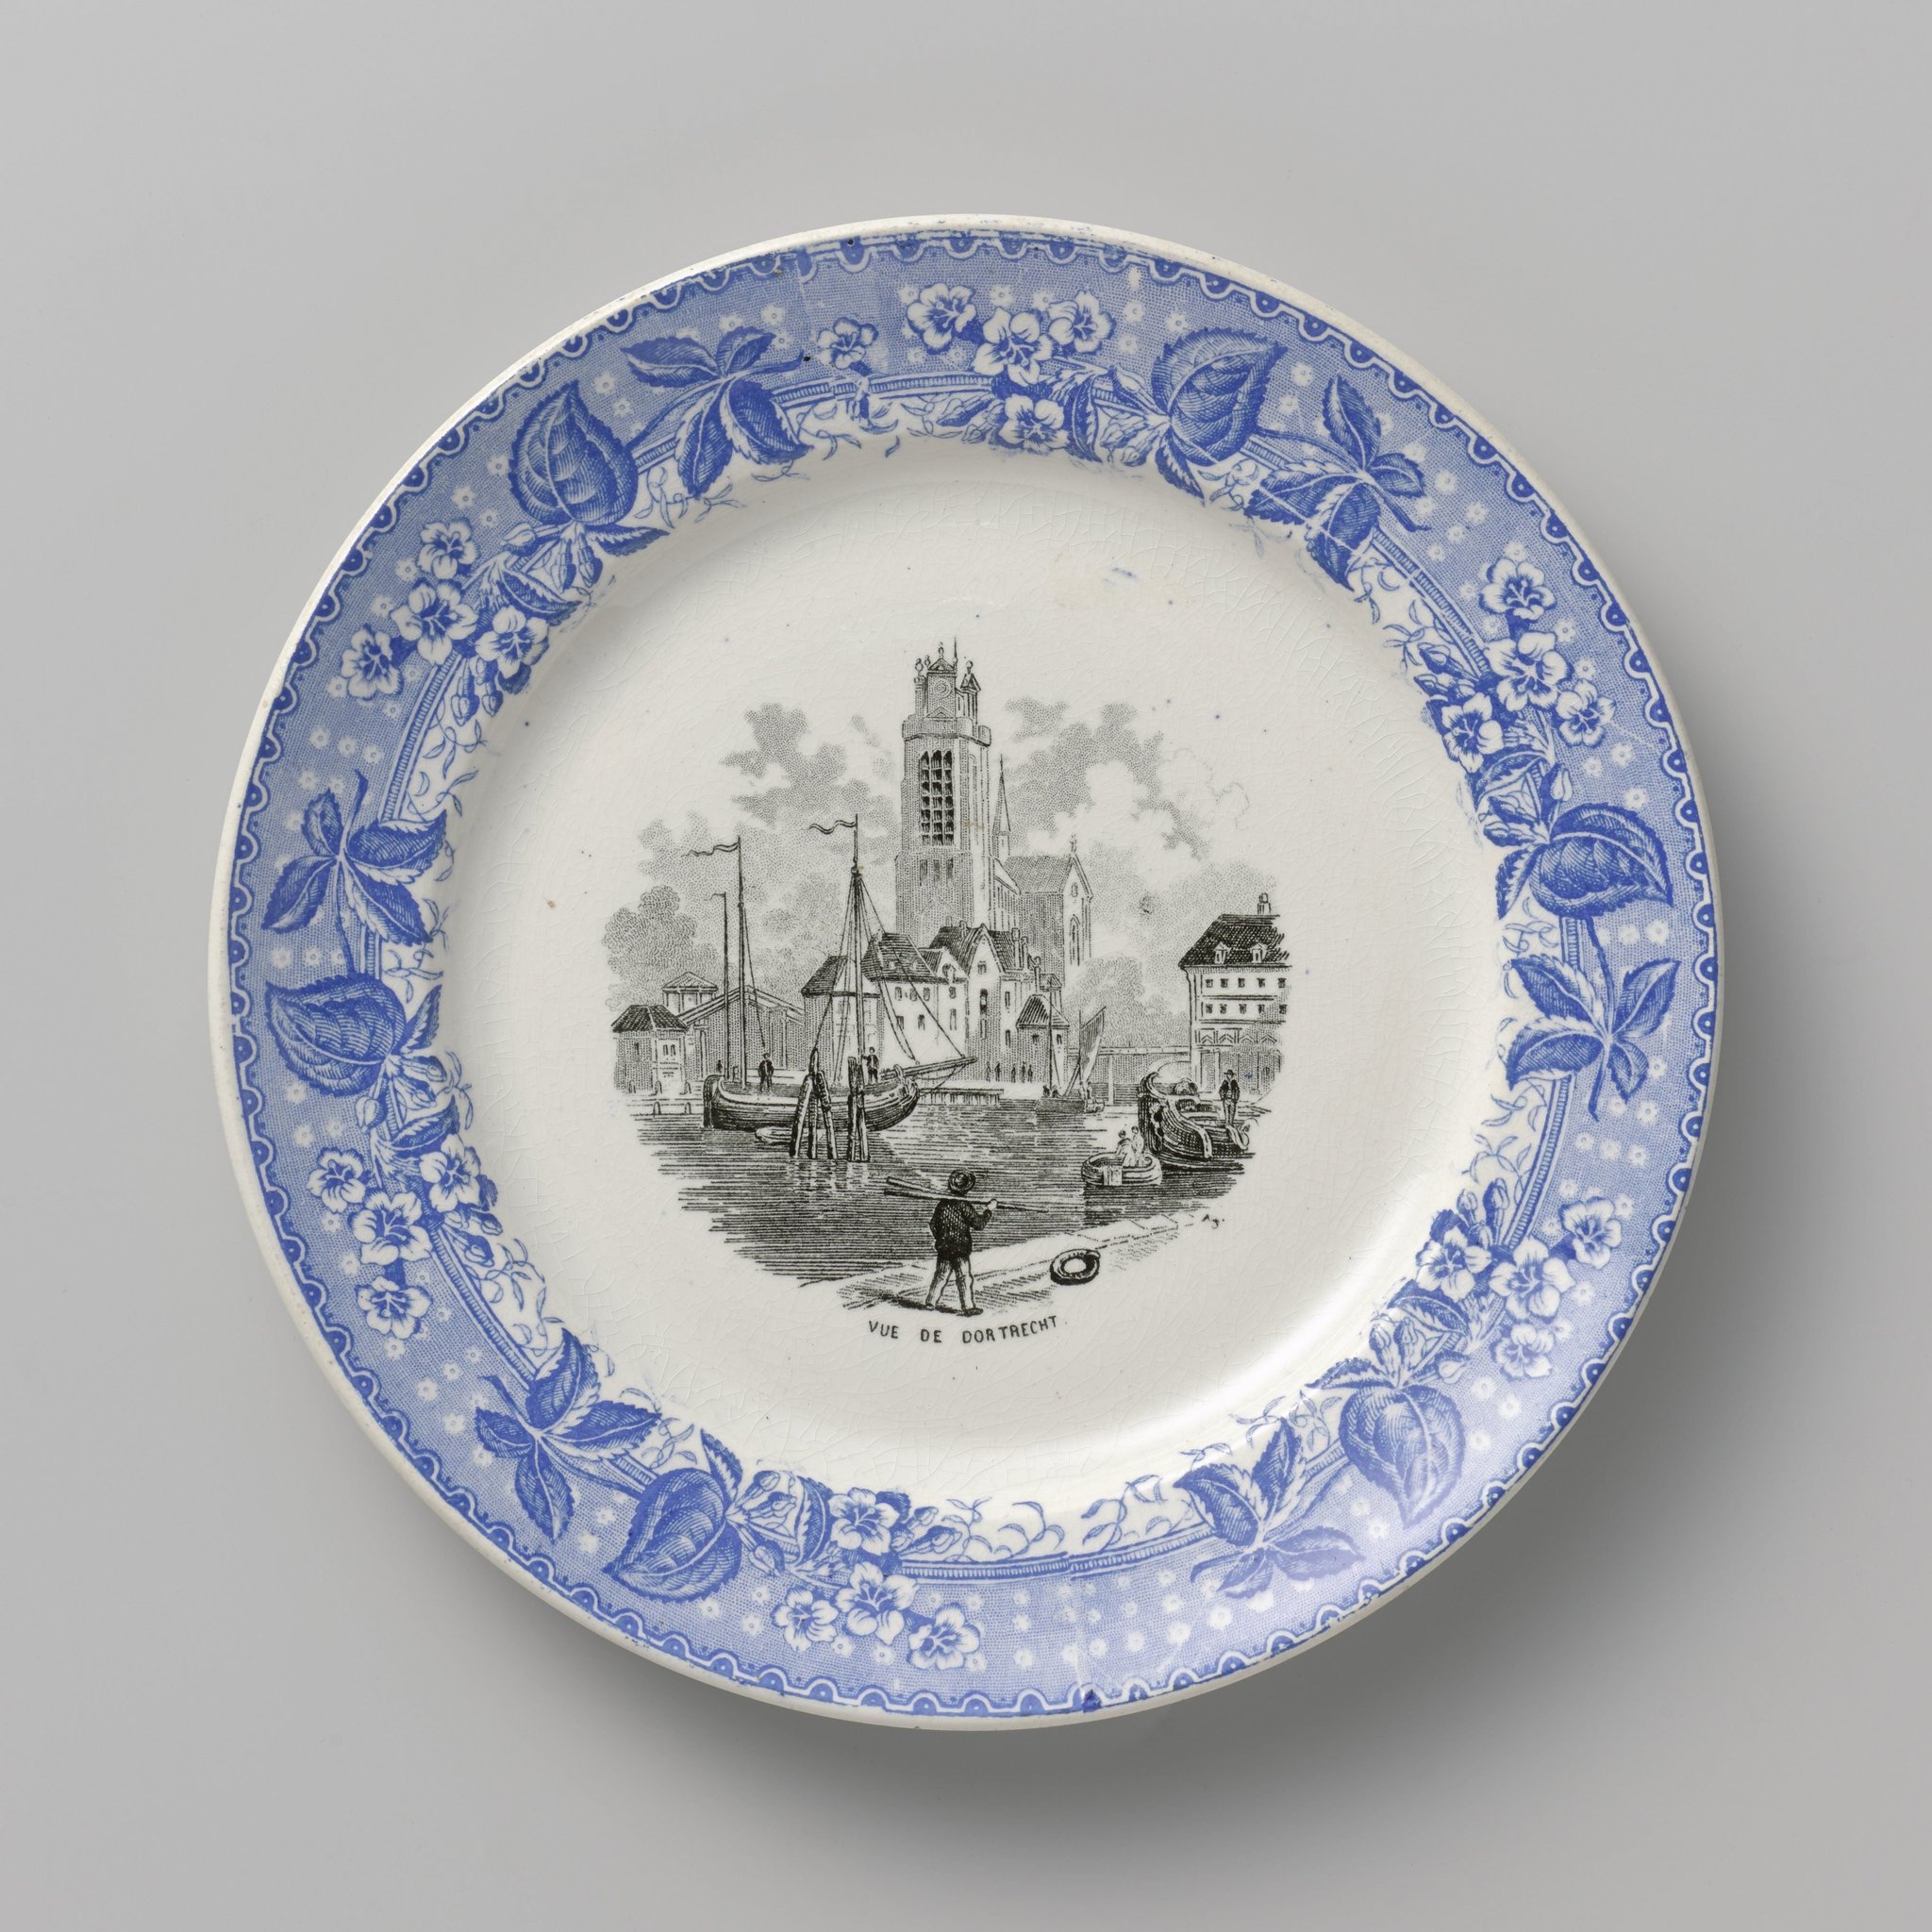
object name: plate dish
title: Bord met op het plat een gezicht op Dordrecht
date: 1863-1958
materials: earthenware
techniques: transfer decoration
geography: maastricht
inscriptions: inscription: ‘VUE DE DORTRECHT’, mark: ‘SOCIÉTÉ CÉRAMIQUE MAESTRICHT’, check stamp: ‘B 5 (? of 3)’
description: Bord van aardewerk met zwart en blauw transferdecor. Op het plat in zwarte transferdruk een gezicht op Dordrecht. Onder de voorstelling de tekst: VUE DE DORTRECHT. De rand van het bord met een blauwe transferdruk met onder andere blauwe bloemen en bladeren.